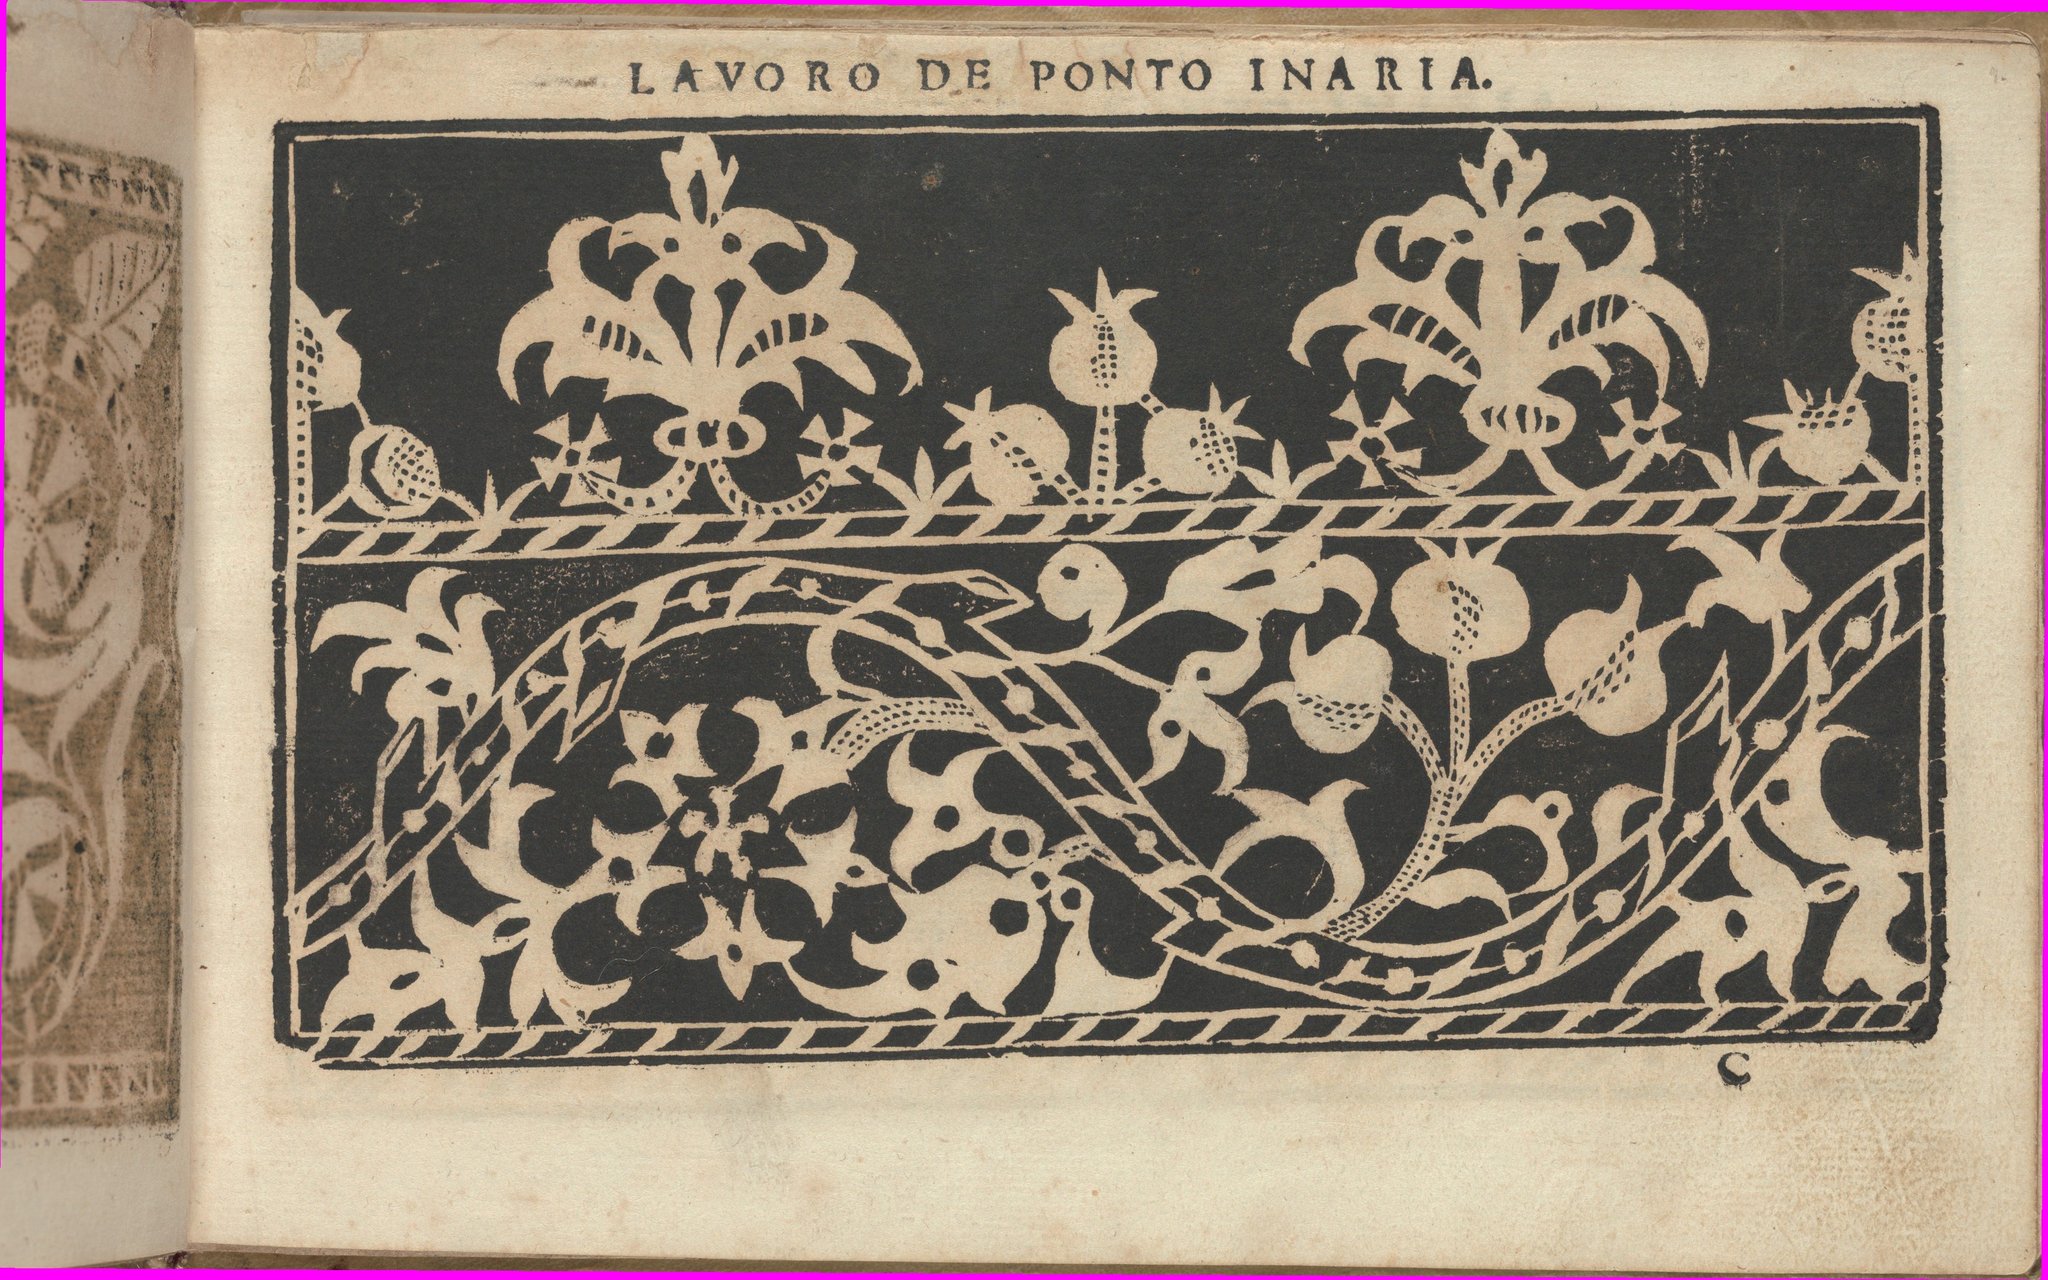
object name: book print ornament architecture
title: Studio delle virtuose Dame, page 9 (recto)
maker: isabella catanea parasole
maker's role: designer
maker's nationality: italian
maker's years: 1565-1625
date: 1597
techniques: woodcut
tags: fruit,flowers